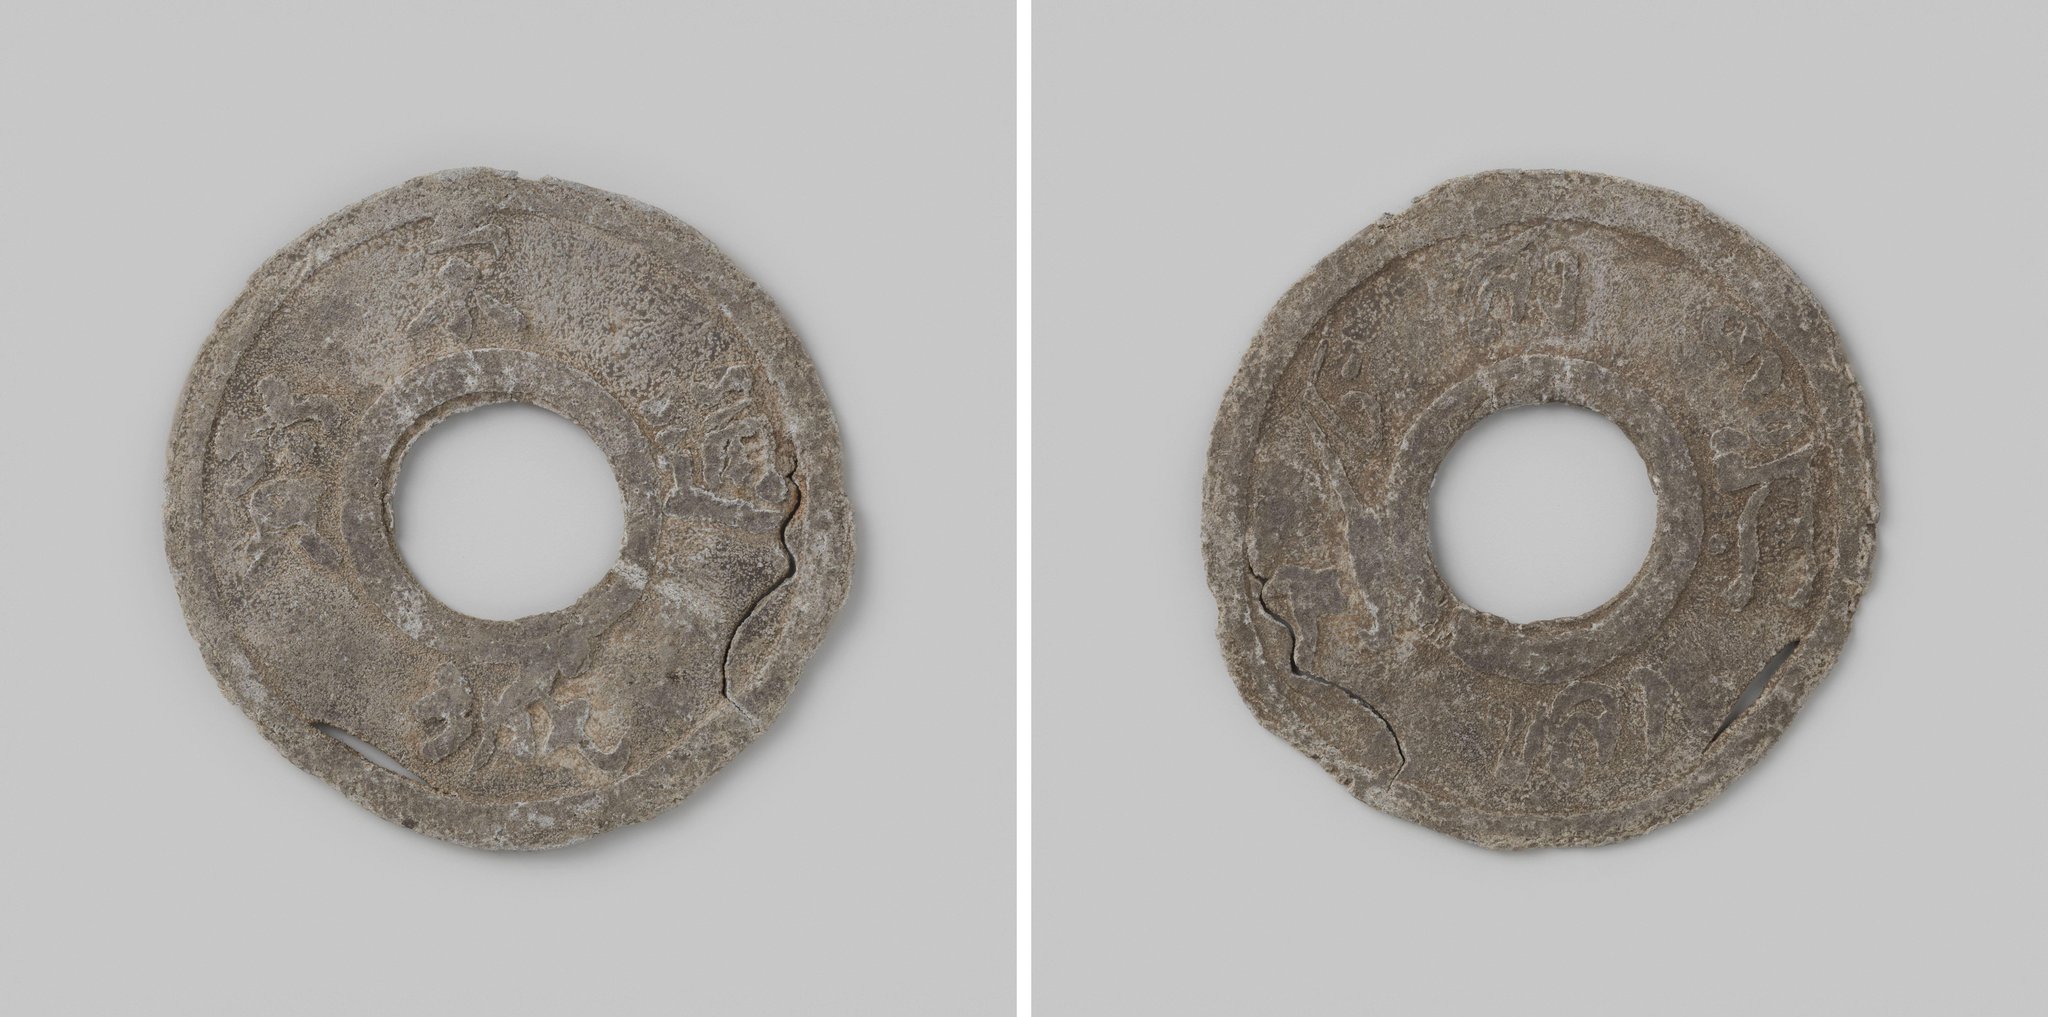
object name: coin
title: Maleise staat Sanggora, deel van Thailand, munt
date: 1820-1860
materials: tin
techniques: casting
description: Tinnen munt. Voorzijde: vier kruisgewijze geplaatste Chinese tekens met de betekenis: tsai tch ing thung-pao [=munt van Tsai-tch ing]. Keerzijde: boven en onder Arabische lettertekens met de betekenis: negri [=land] Sangggora en links en rechts Thaise lettertekens met dezelfde plaats-aanduidiing in het Thais: Song Khla. In het midden zeshoekig gat.